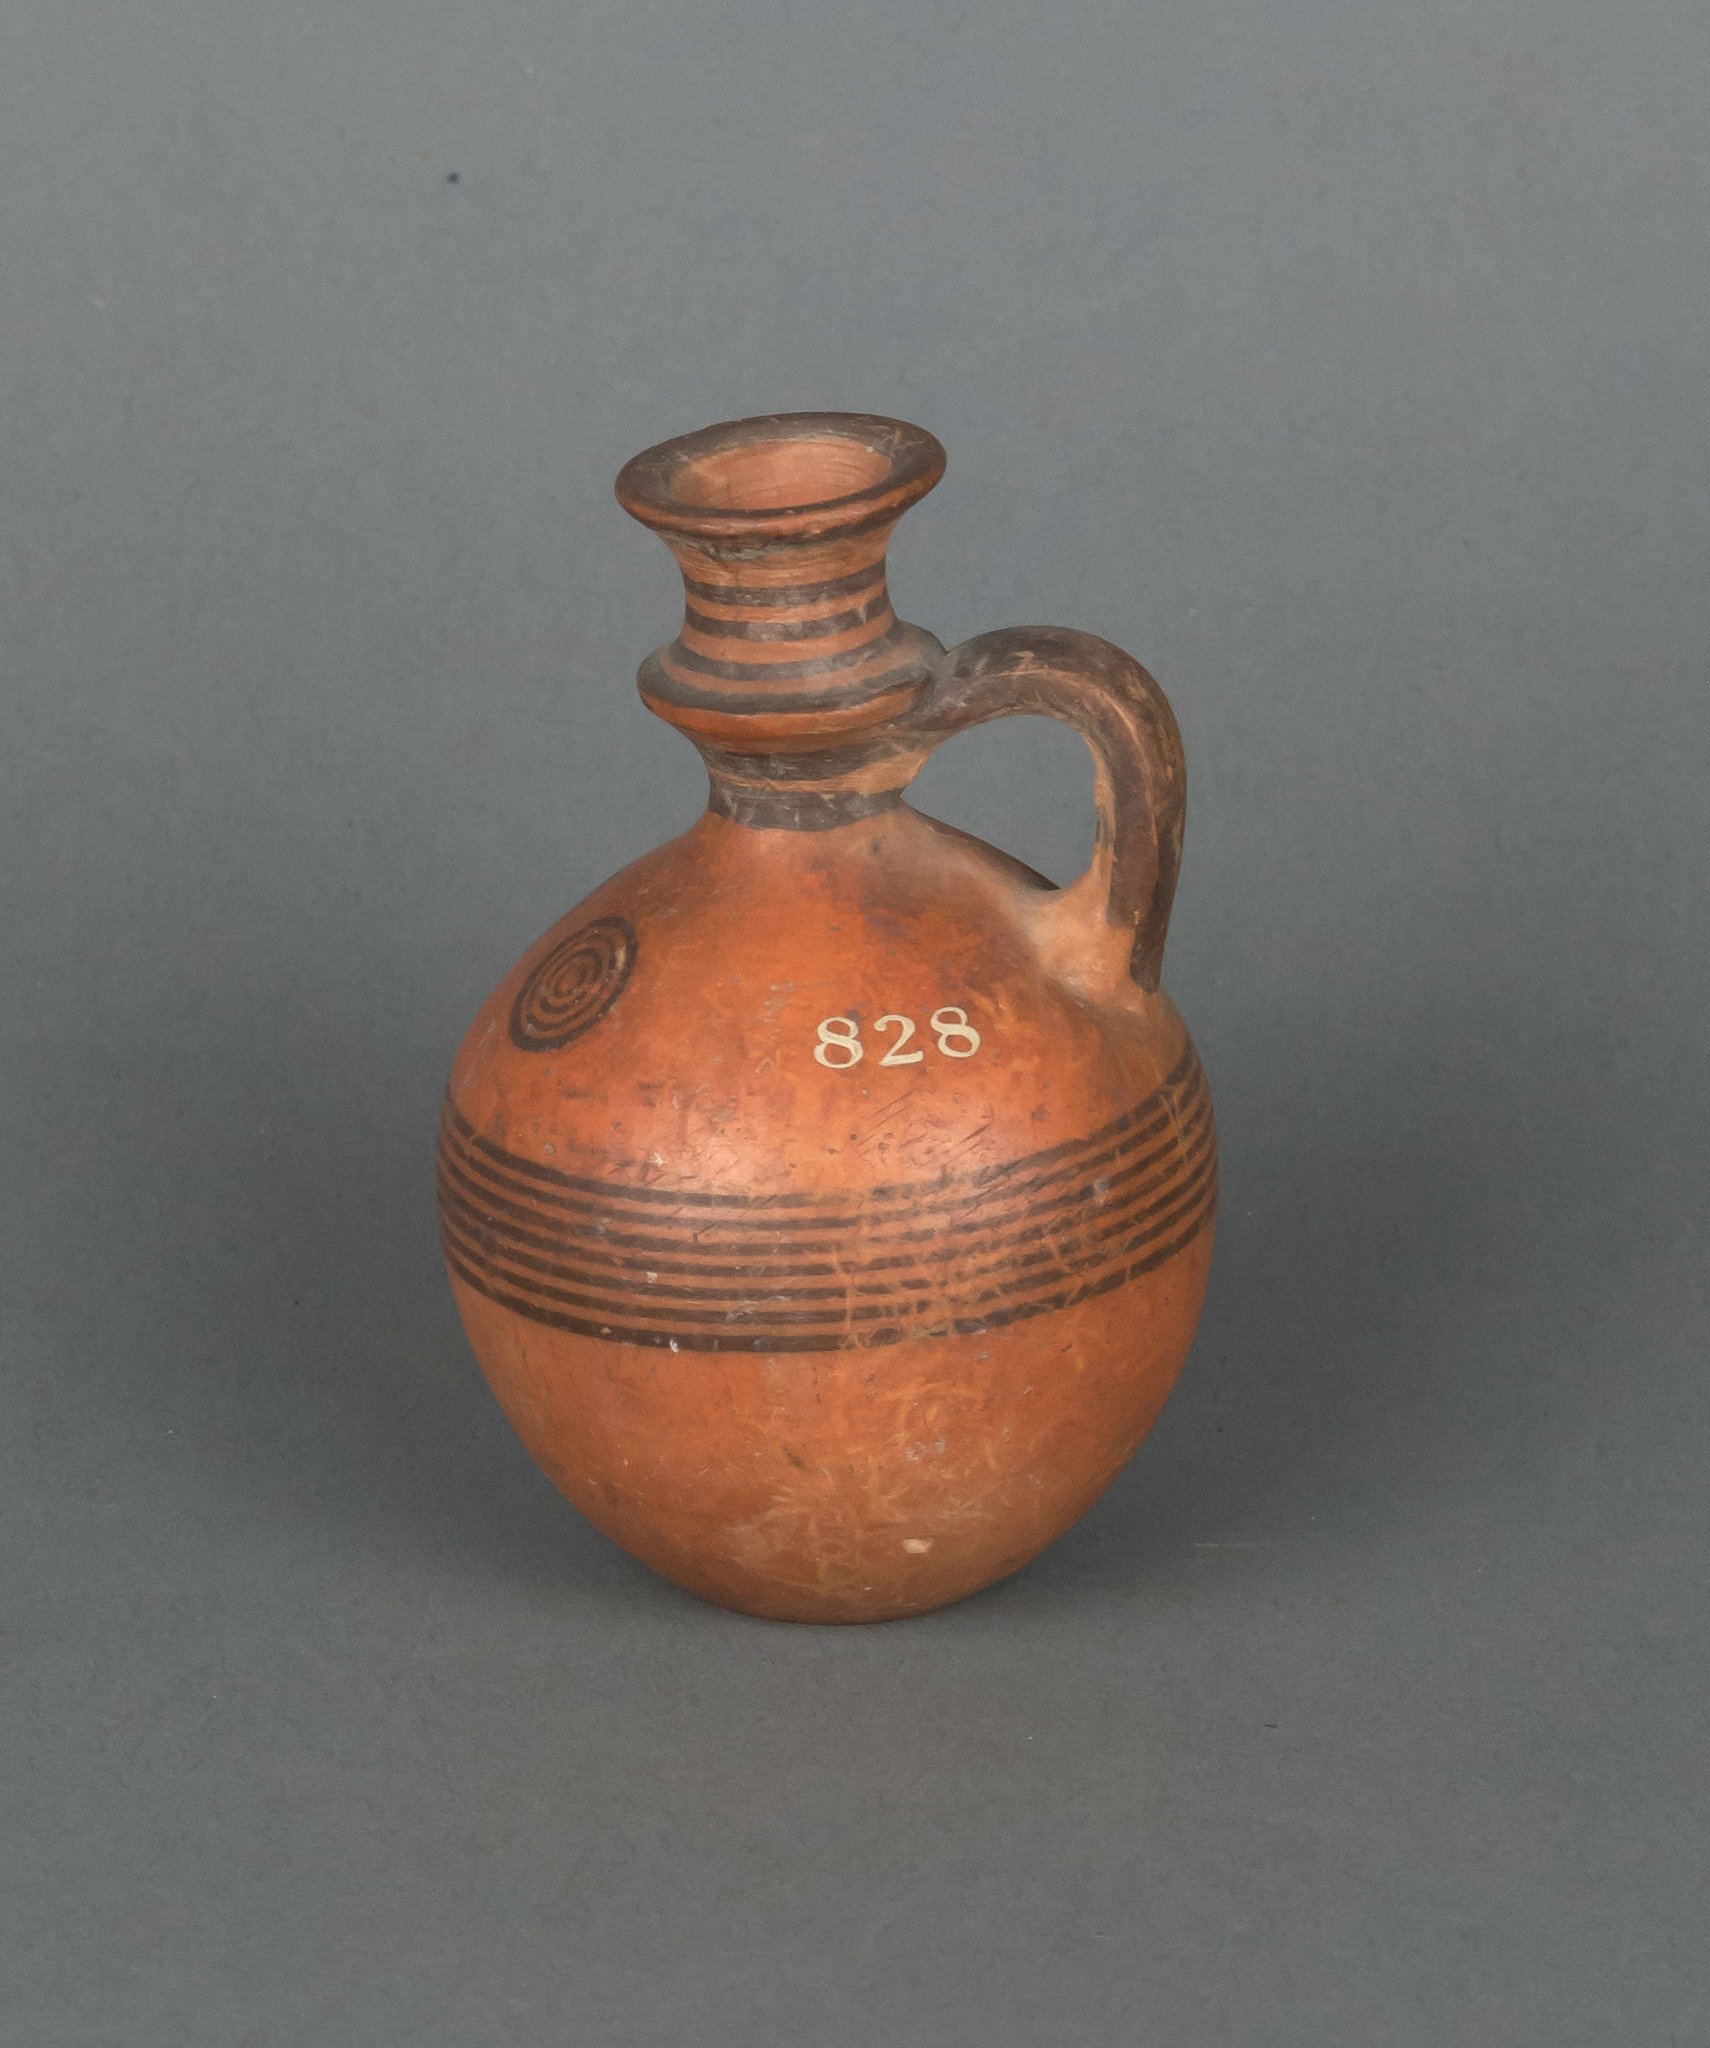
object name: juglet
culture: cypriot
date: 750-600 BCE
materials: terracotta